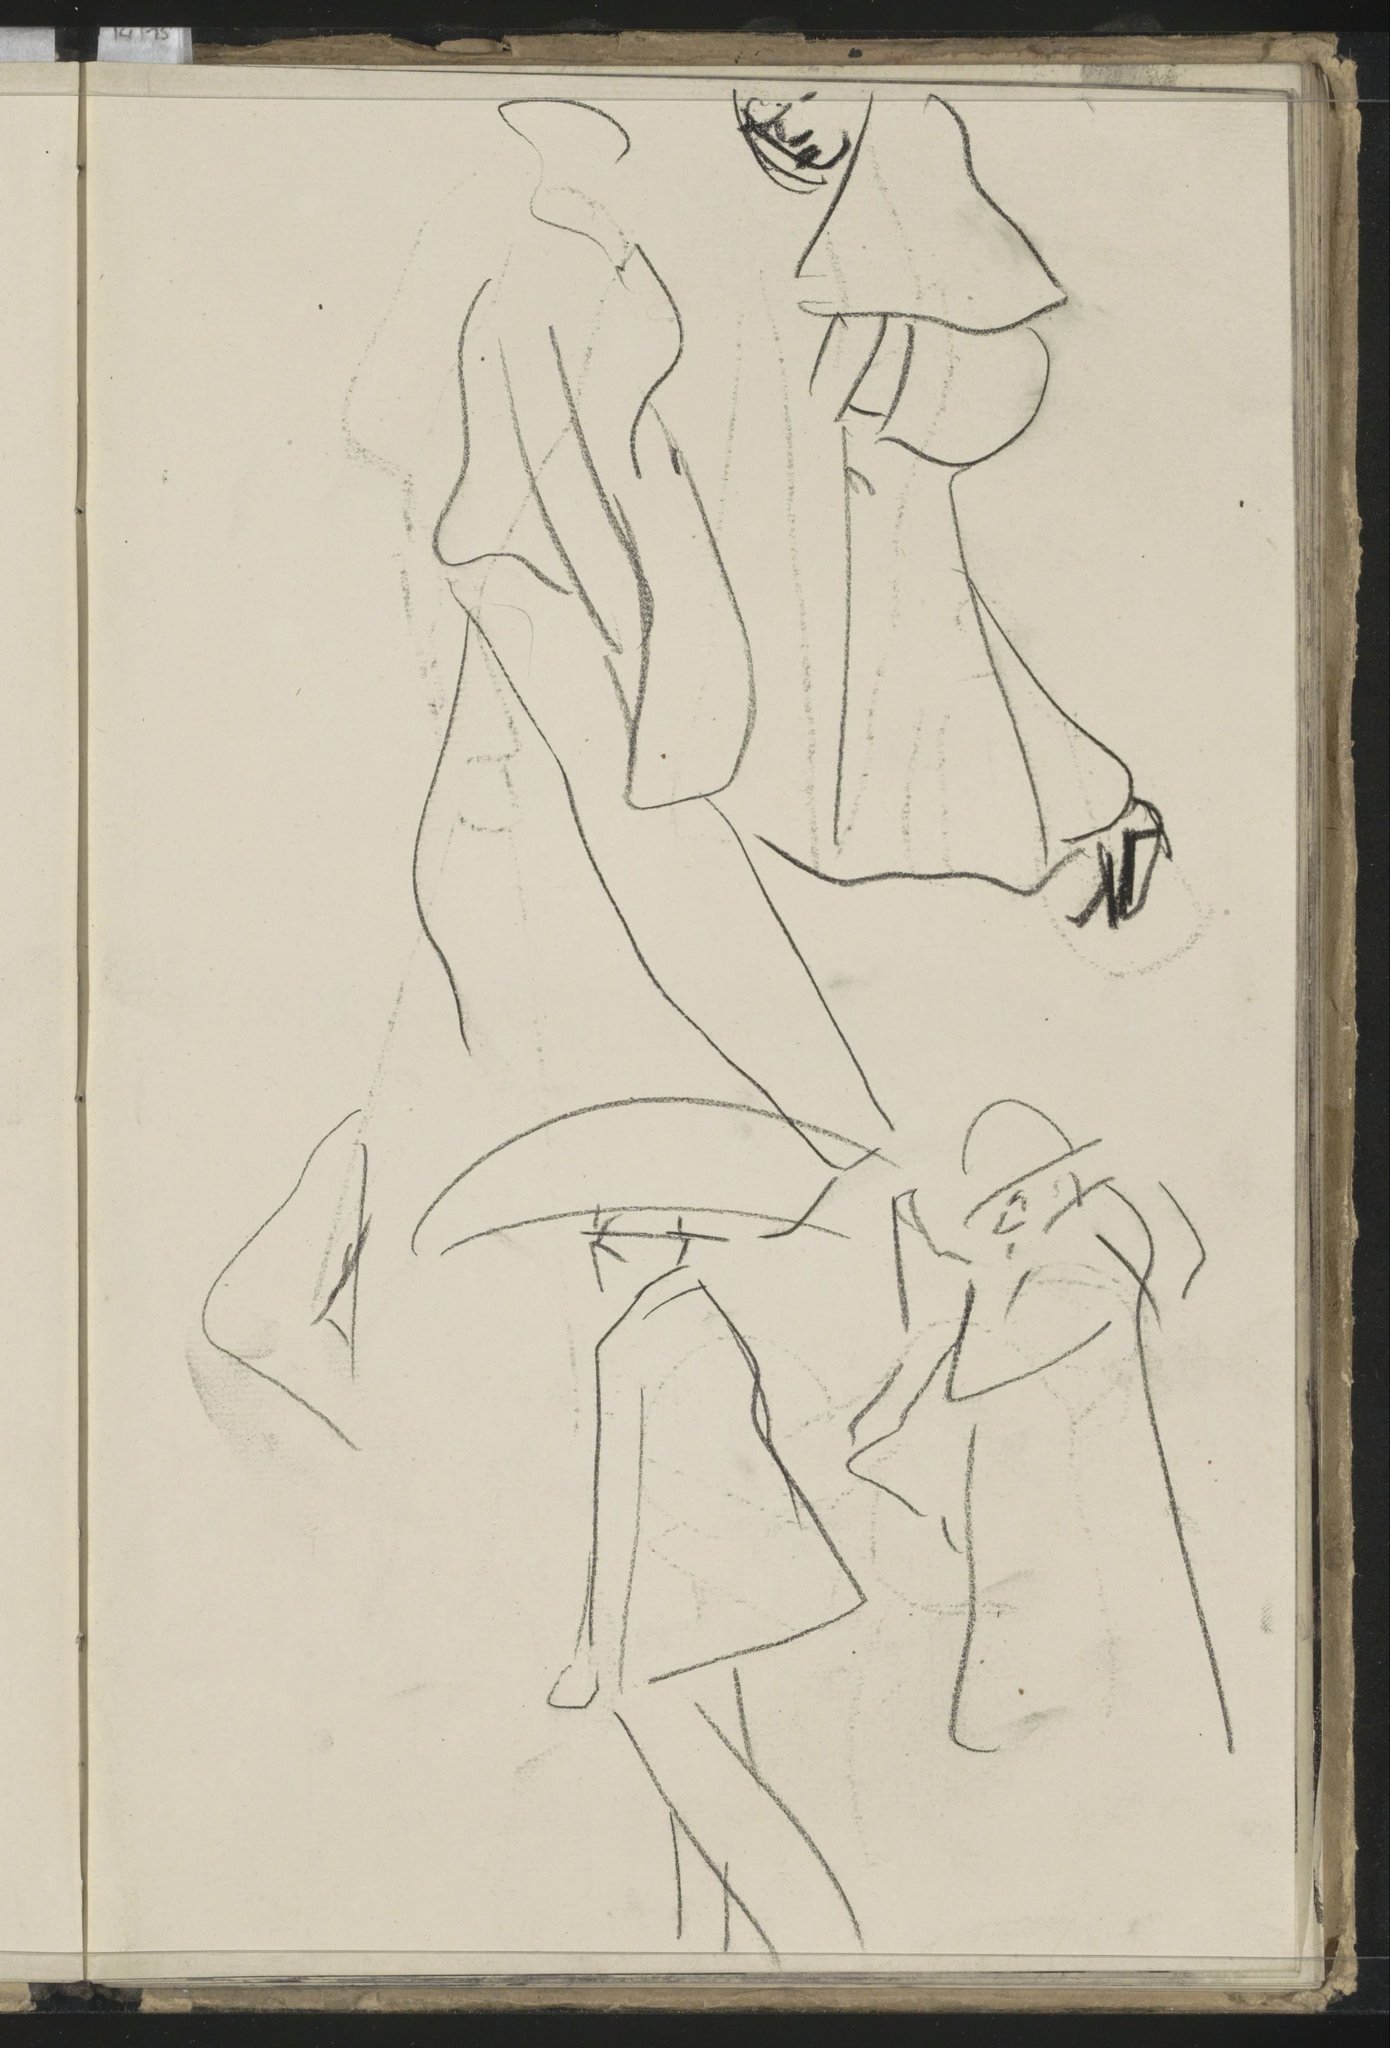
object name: sketchbook leaf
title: Lopende mannen en vrouwen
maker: carel adolph lion cachet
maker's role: draughtsman, print maker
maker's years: 1864-1945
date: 1890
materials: chalk, paper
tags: walking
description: Blad 8 recto uit een schetsboek met 38 bladen.